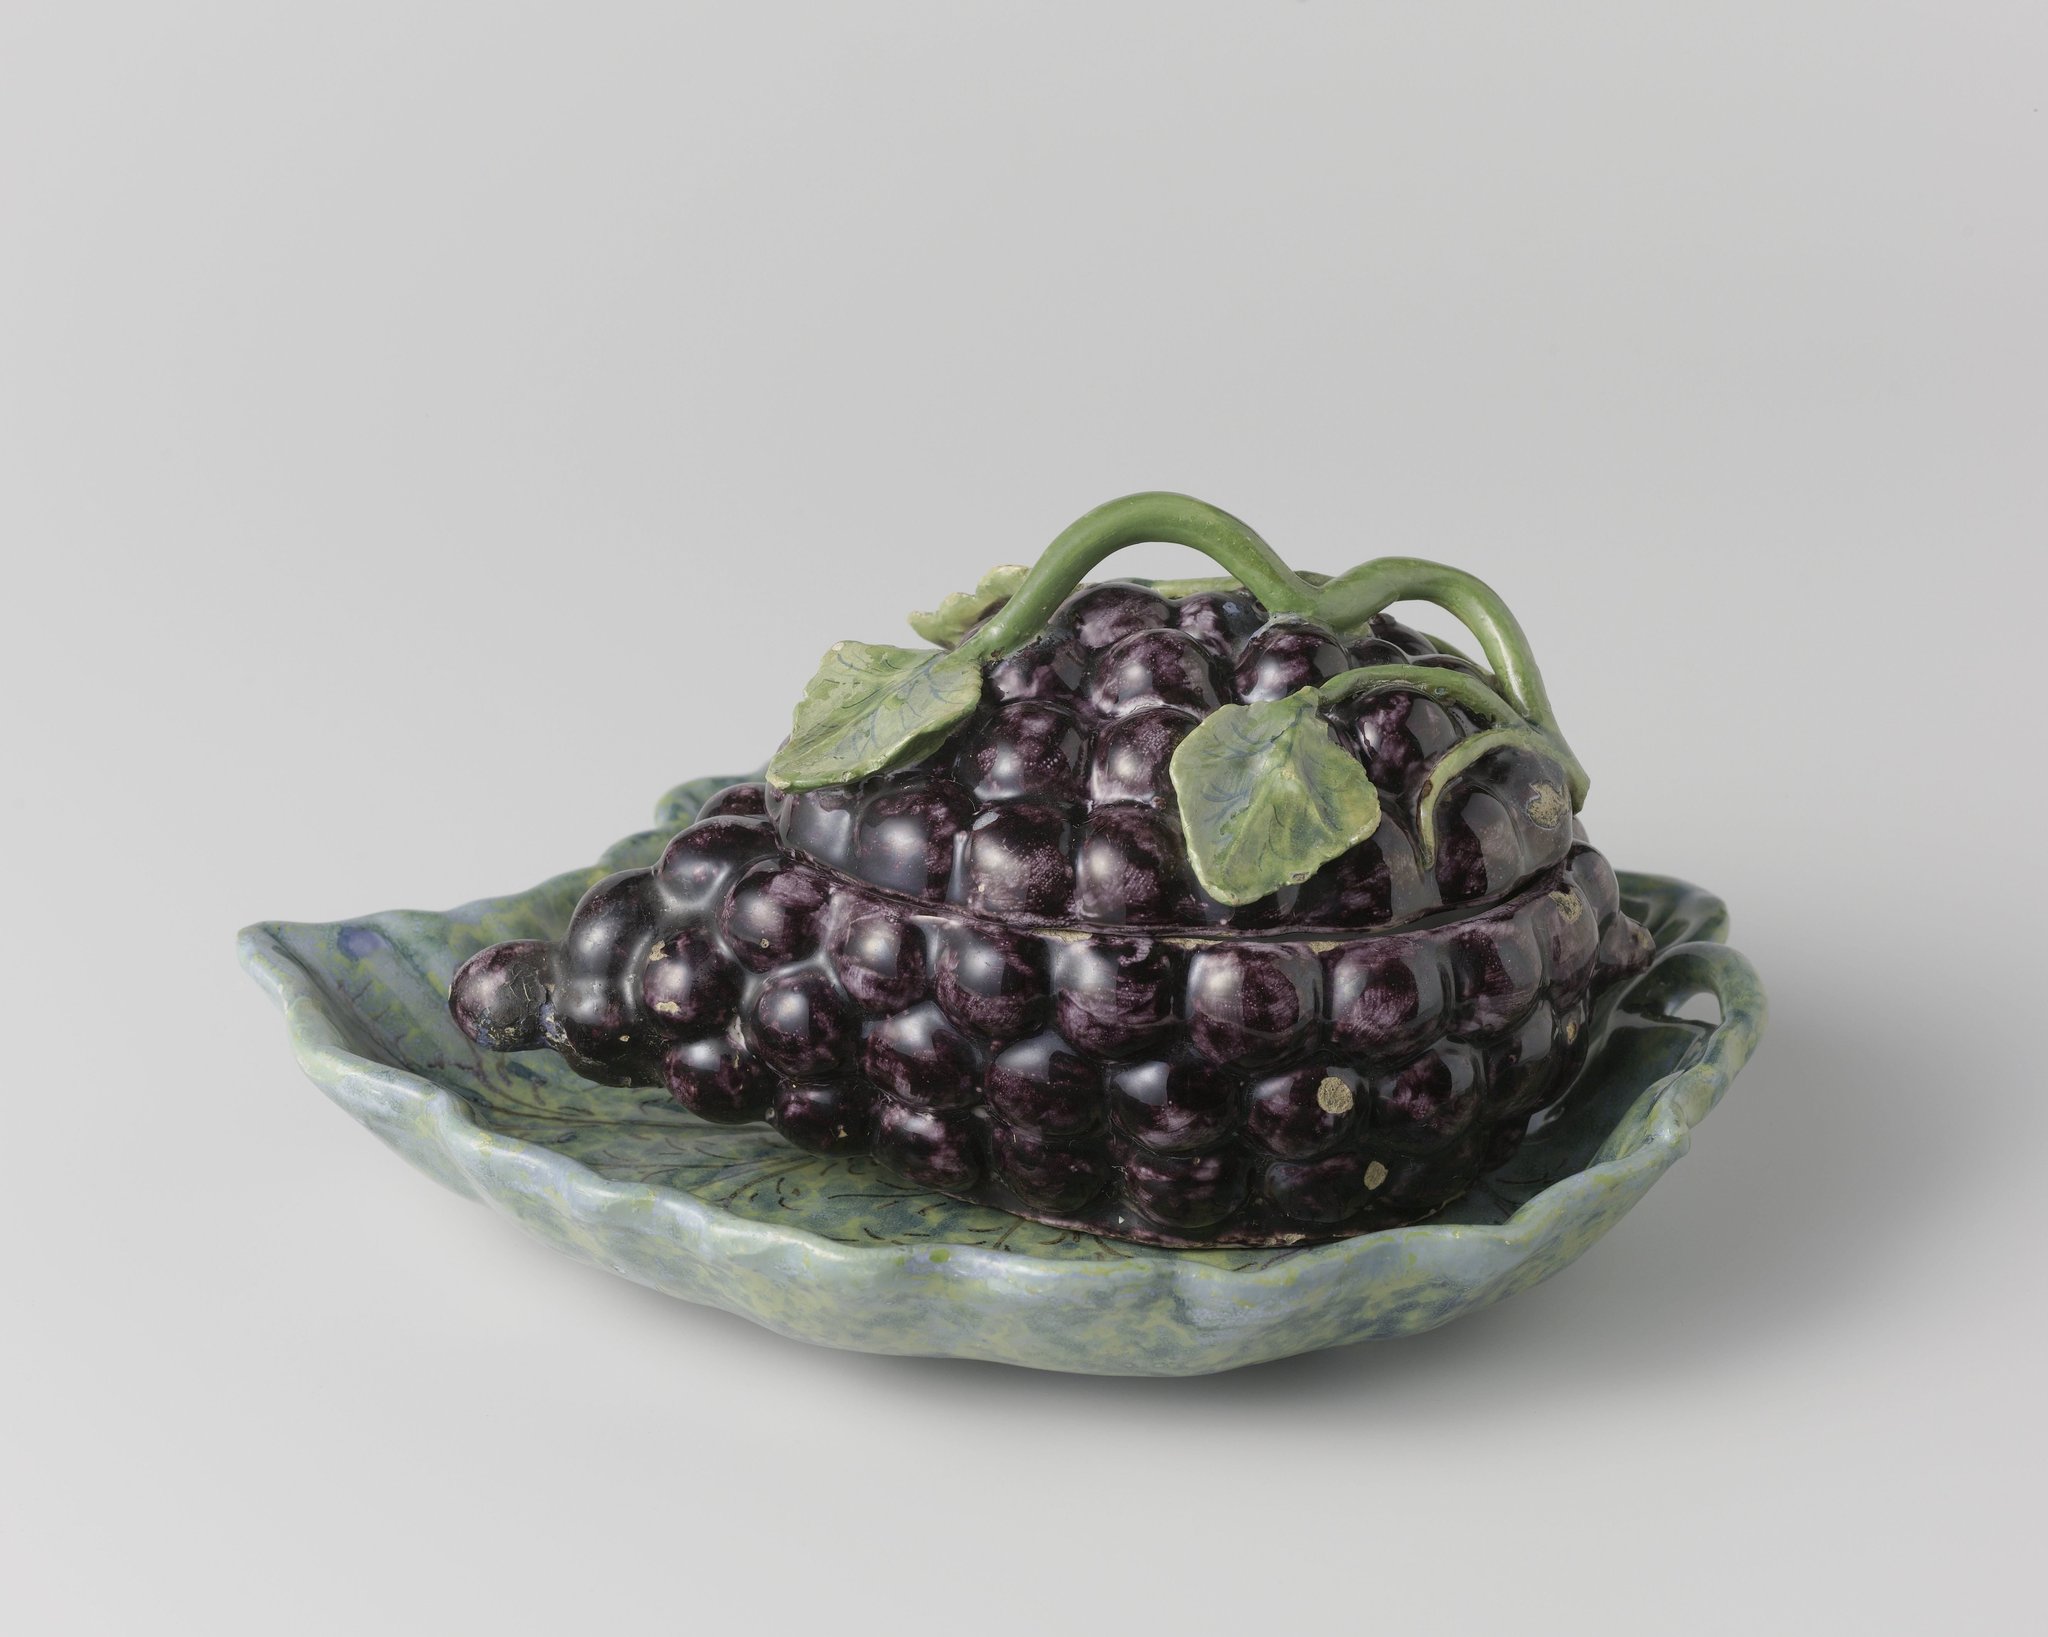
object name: platter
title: Onderschotel van een doos van faience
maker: johannes pennis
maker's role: plateelbakker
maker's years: 1702-1788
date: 1724-1764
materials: faience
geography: delft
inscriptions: mark: ‘IP (ineen)’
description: Onderschotel van een doos van faience, in de vorm van een druivenblad. Veelkleurig beschilderd.